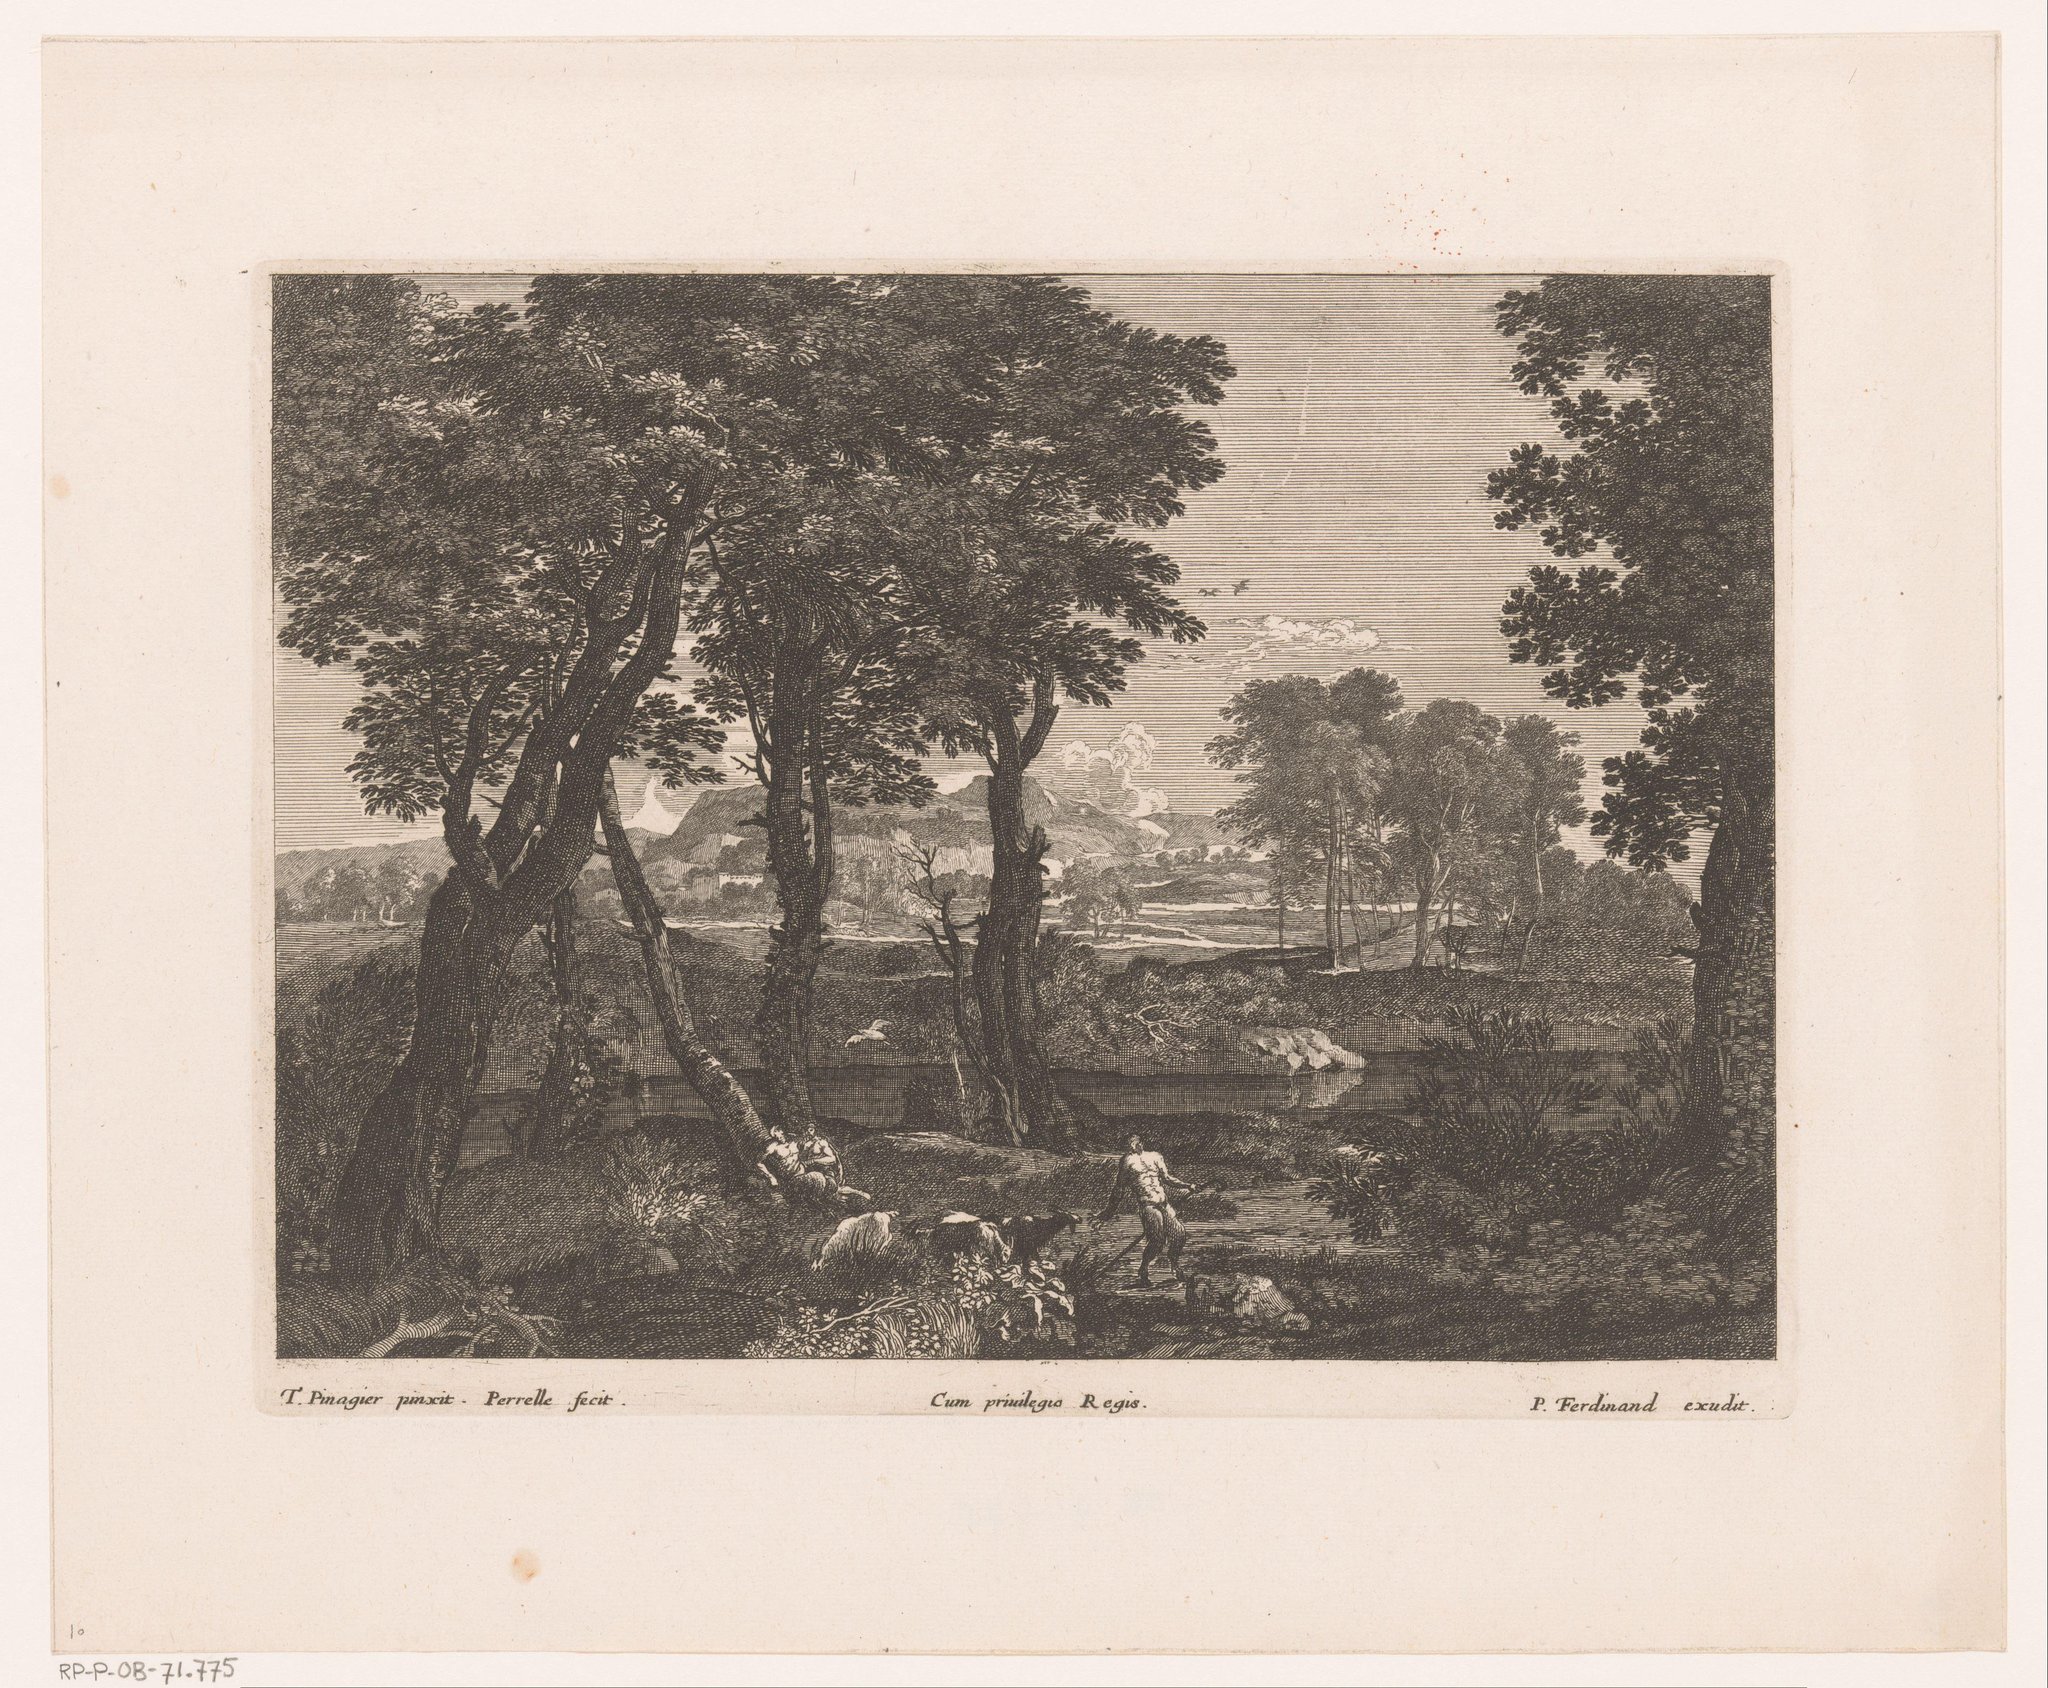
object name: print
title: Saters aan voet van bomen bij rivier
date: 1627-1655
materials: paper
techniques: engraving, etching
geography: france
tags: river, satyr(s) (in general)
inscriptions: collector's mark: Lugt 240